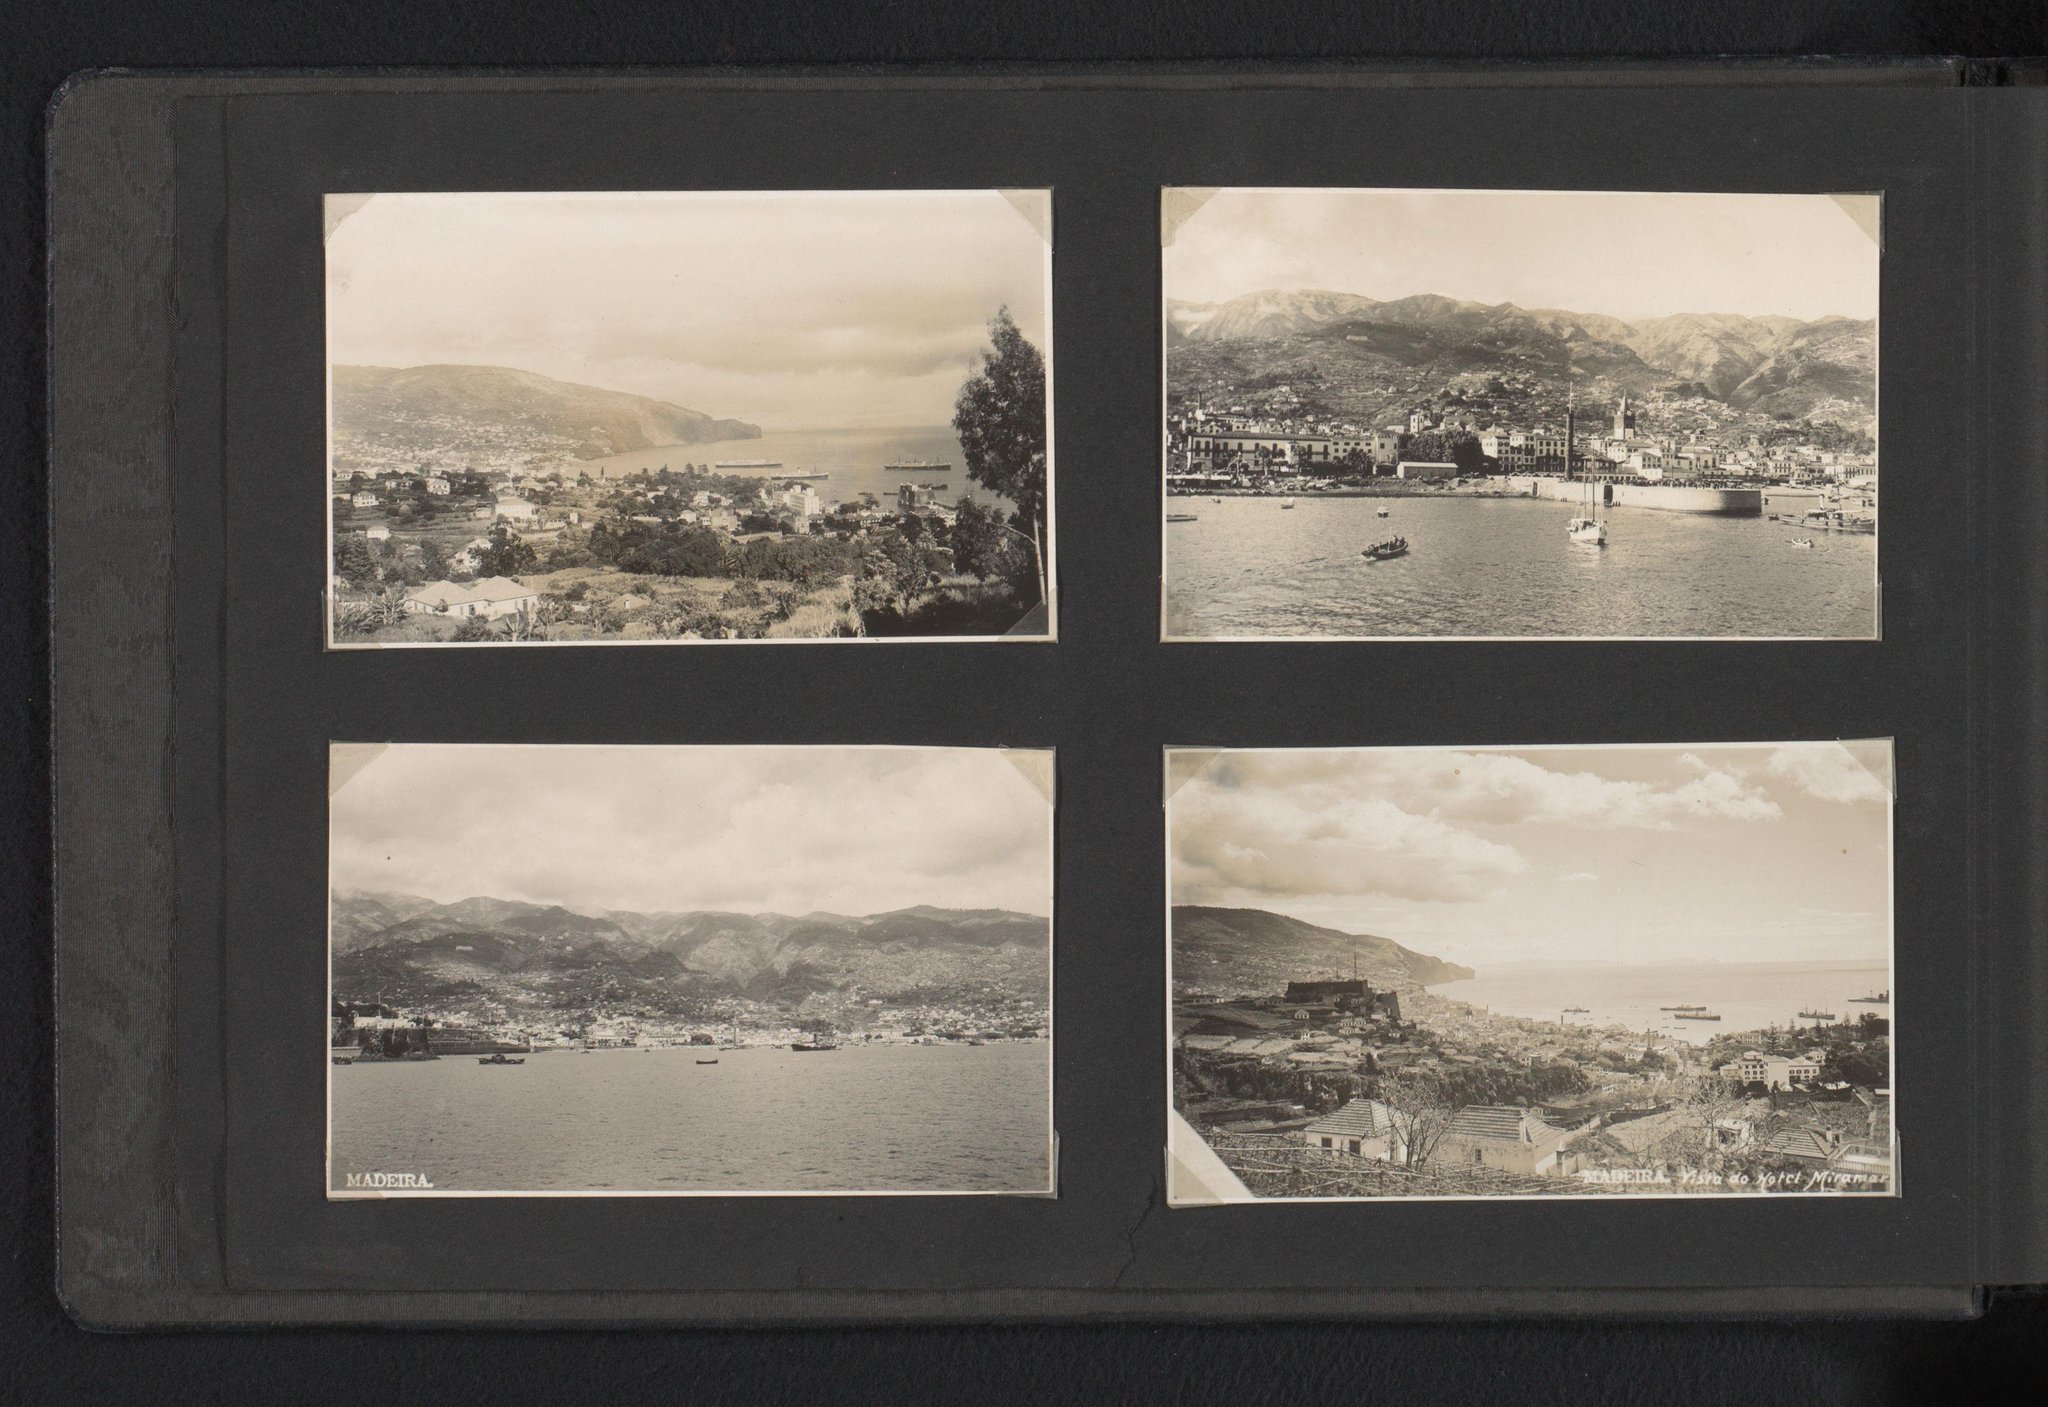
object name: album leaf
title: Vier foto's, waarvan twee prentbriefkaarten, van gezichten op Madeira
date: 1933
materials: paper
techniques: gelatin silver print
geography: madeira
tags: island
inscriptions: inscription: ‘1. haven te Madeira/ 2 " "’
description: Deze foto's maken deel uit van een album.